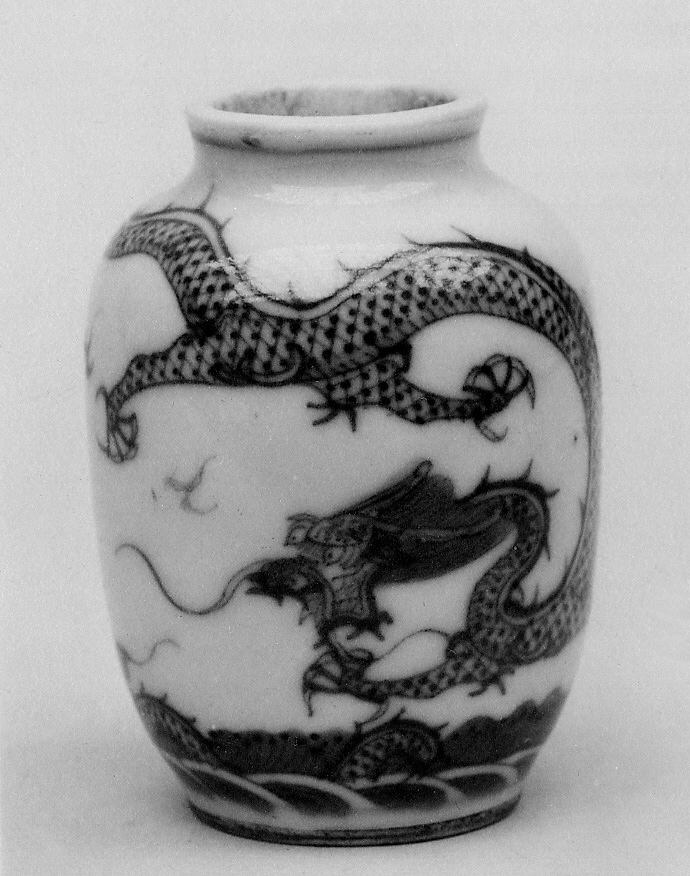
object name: snuff bottle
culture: chinese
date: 1701-1800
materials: porcelain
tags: dragons